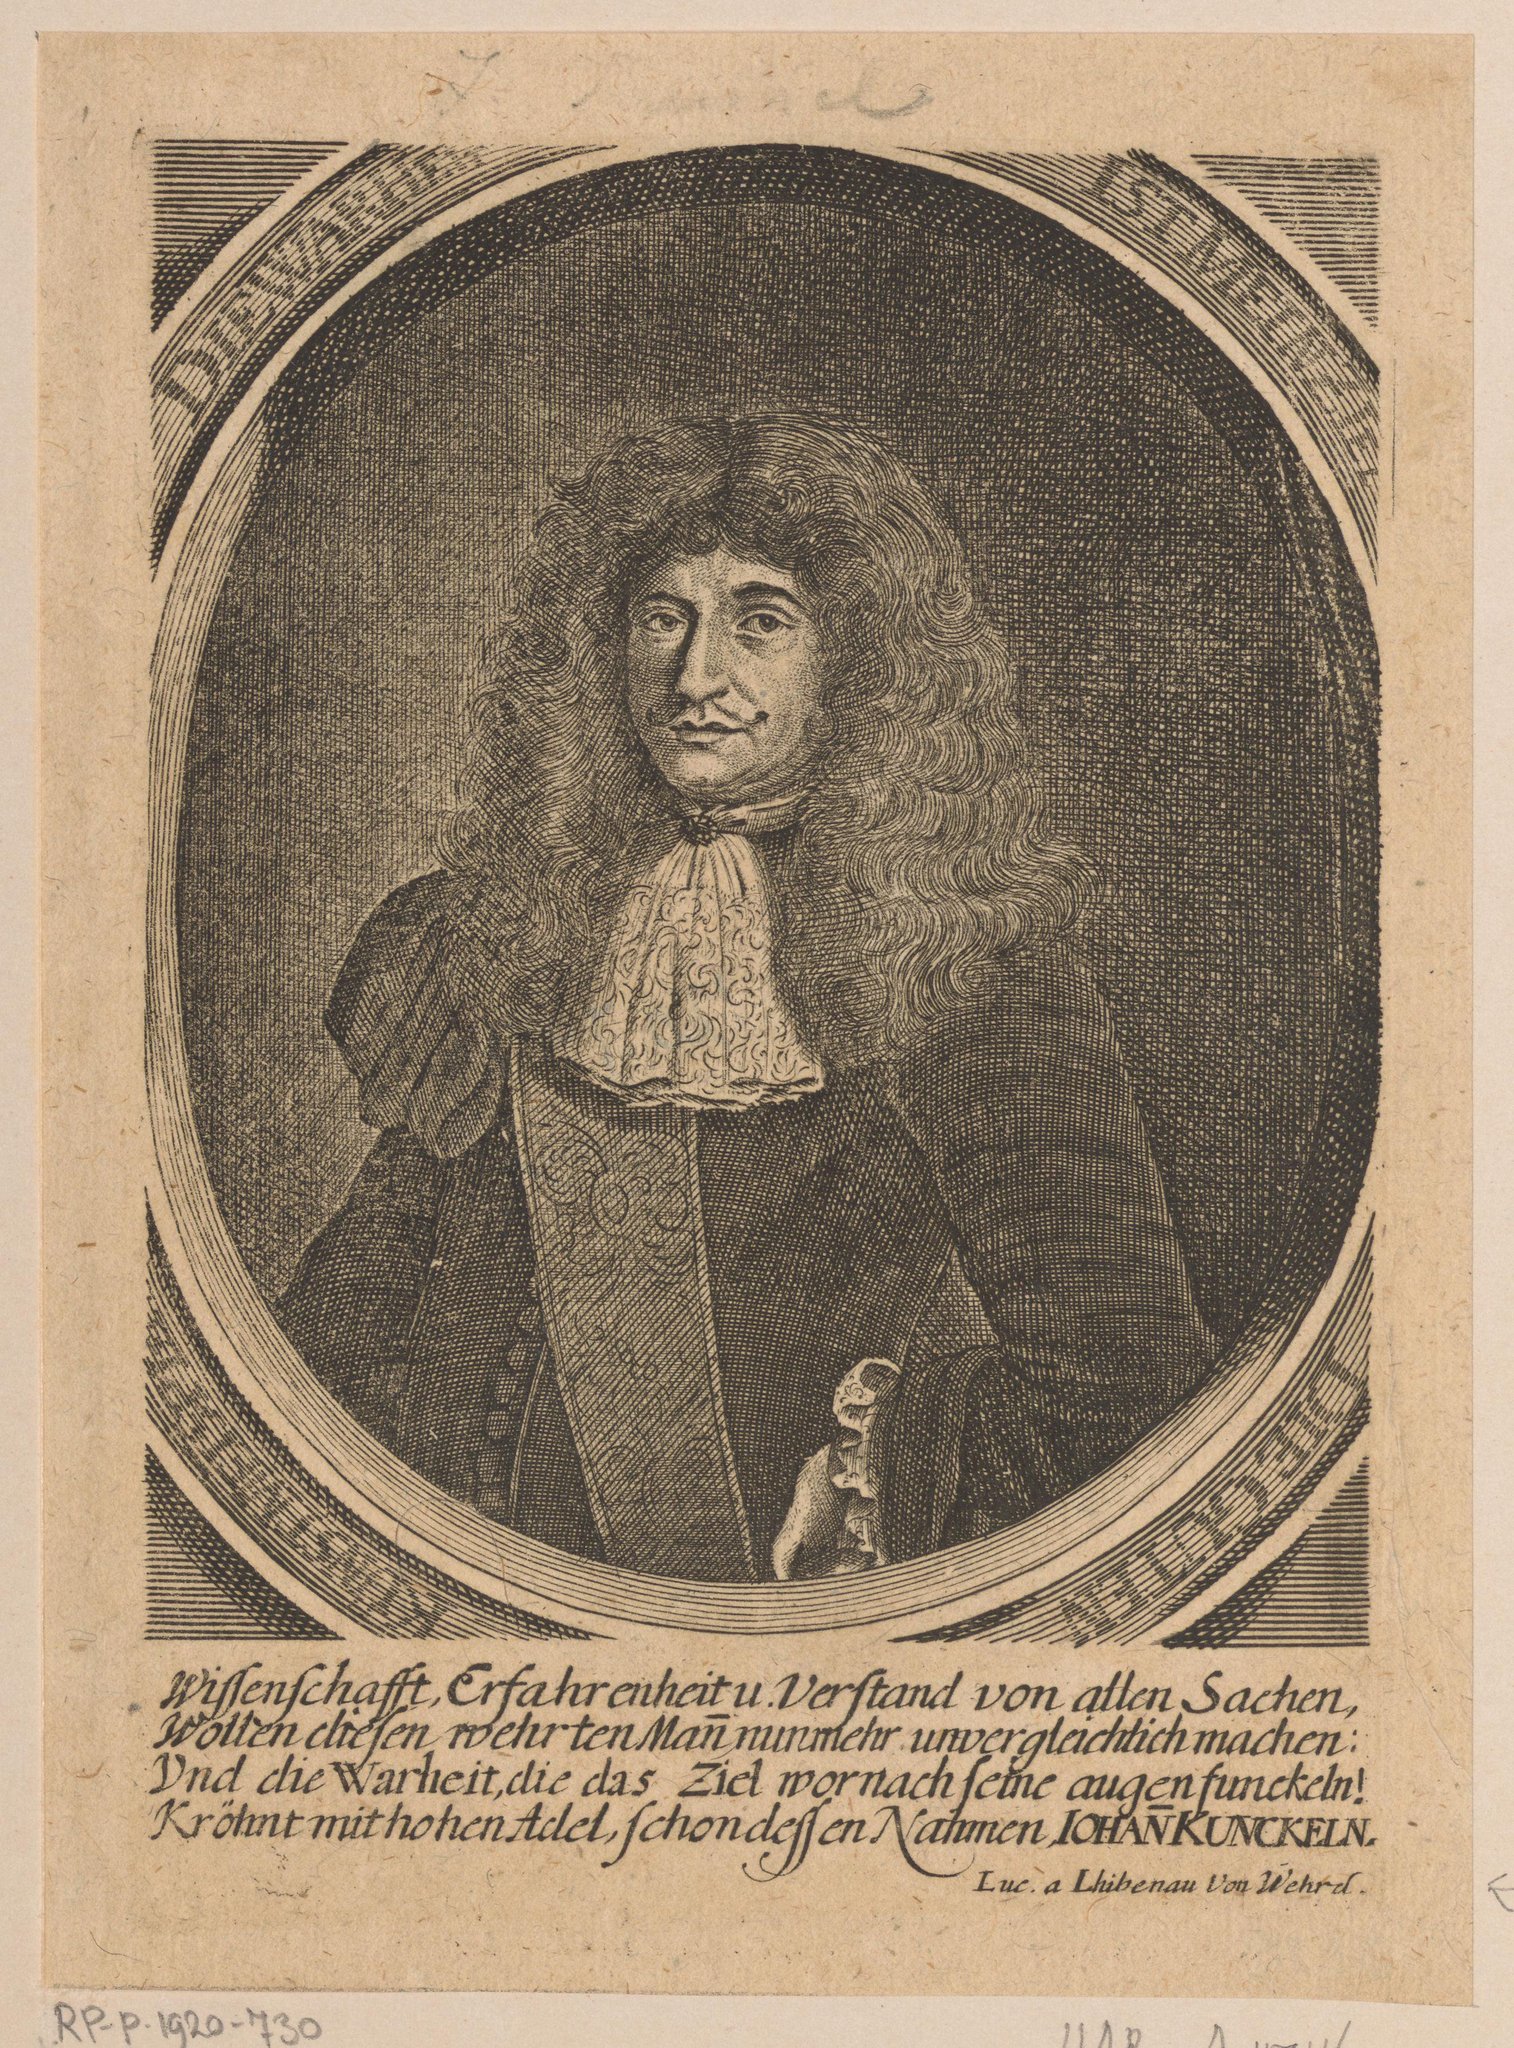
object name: print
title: Portret van Johann Kunckel von Löwenstjern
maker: nicolaus häublin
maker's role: print maker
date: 1679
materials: paper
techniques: engraving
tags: manufacturer, johann kunckel von löwenstjern, historical persons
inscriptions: collector's mark: Lugt 2228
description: Prent mogelijk uit: Kunckel von Löwenstjern, Johann. Ars vitraria experimentalis (...). Frankfurt en Leipzig: Johann Kunckel von Löwenstjern, 1679.